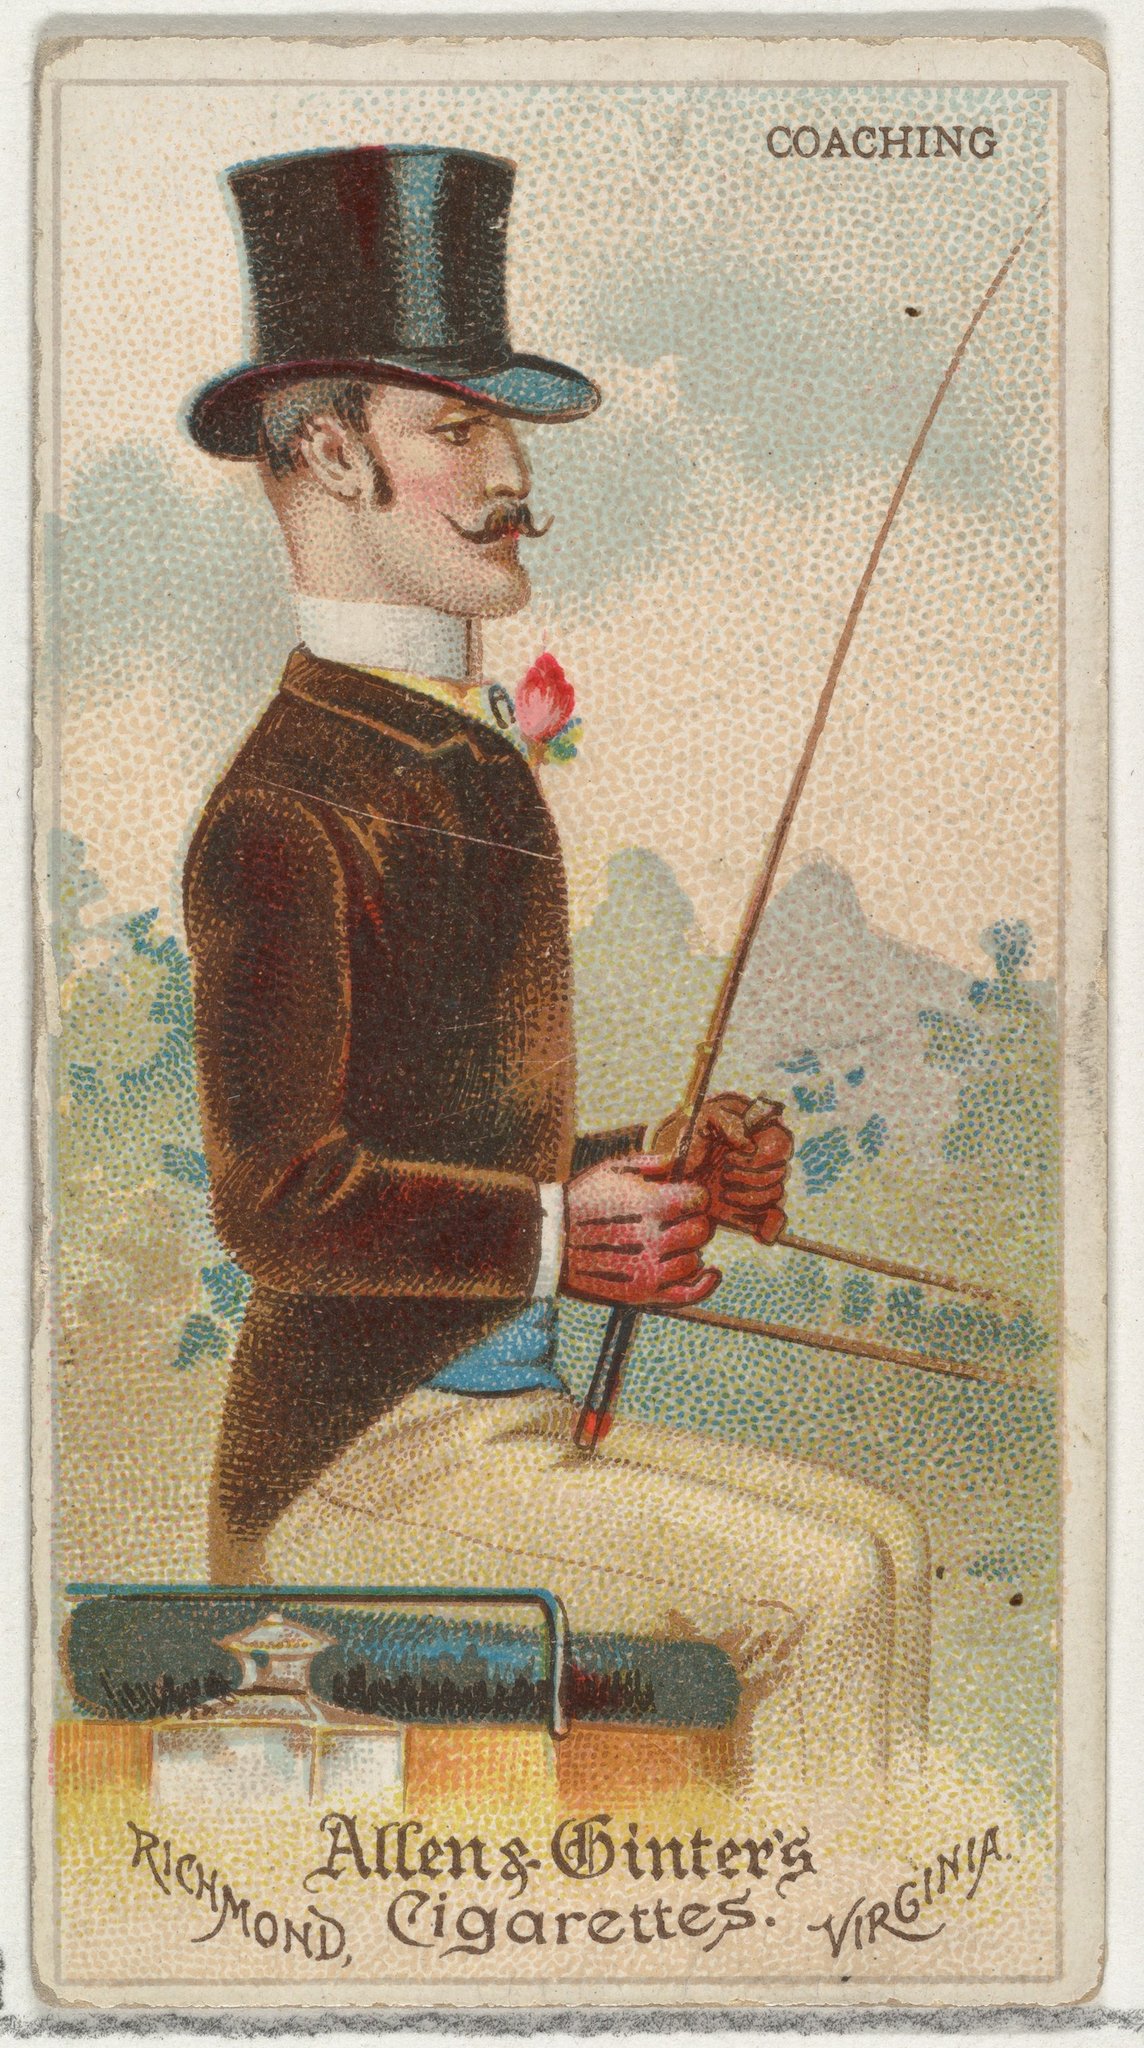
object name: print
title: Coaching, from World's Dudes series (N31) for Allen & Ginter Cigarettes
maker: allen & ginter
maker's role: publisher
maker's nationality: american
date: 1888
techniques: color lithograph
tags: men,profiles